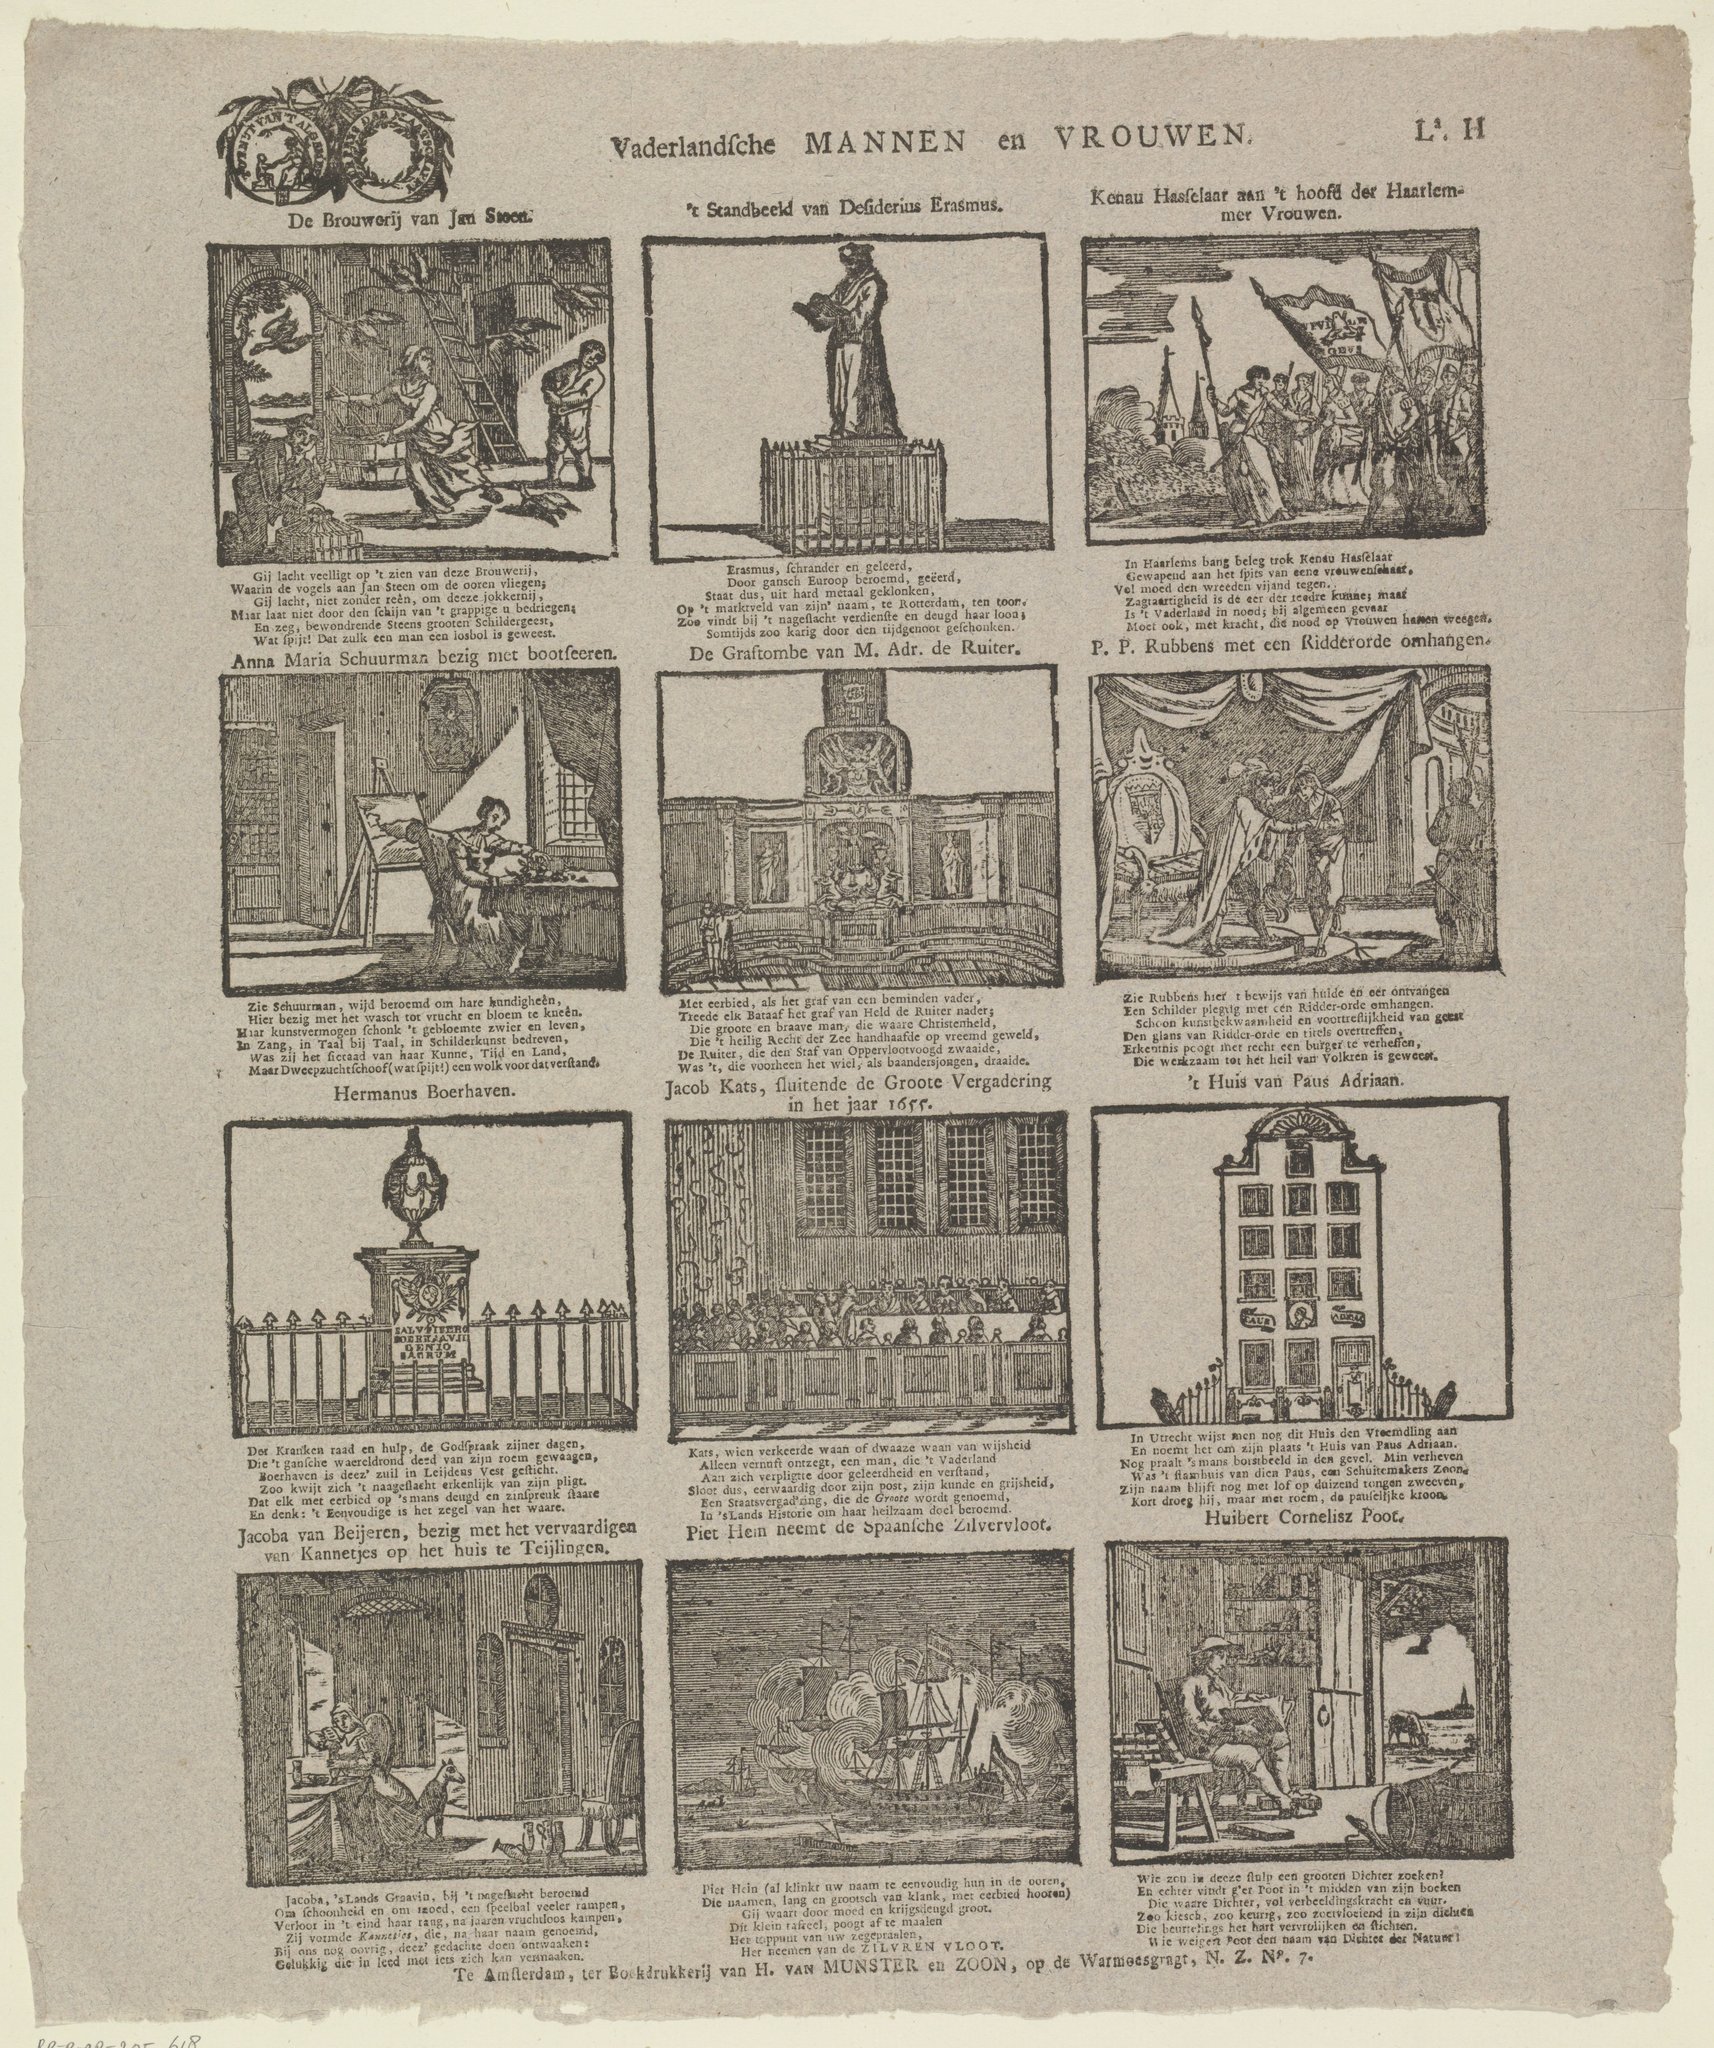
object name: popular print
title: Vaderlandsche mannen en vrouwen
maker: Anonymous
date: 1811-1829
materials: paper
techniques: letterpress printing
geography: amsterdam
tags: cologne, anna maria van schurman, jan havicksz. steen, jacoba of bavaria (countess of hainaut), rotterdam, desiderius erasmus, flushing, michiel adriaenszoon de ruyter, delfshaven, the hague, jacob cats (1577-1660), hubert kornelisz. poot, antwerp, painter, print maker, peter paul rubens, utrecht, clergyman, hermanus boerhaave, coin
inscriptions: collector's mark: Lugt 2760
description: Blad met 12 voorstellingen van of over beroemde Nederlandse mannen en vrouwen, historische figuren. Linksboven het zegel van de Maatschappij tot Nut van 't Algemeen. Boven elke afbeelding een titel, onder elke afbeelding een zesregelig vers. Genummerd rechtsboven: L.H.